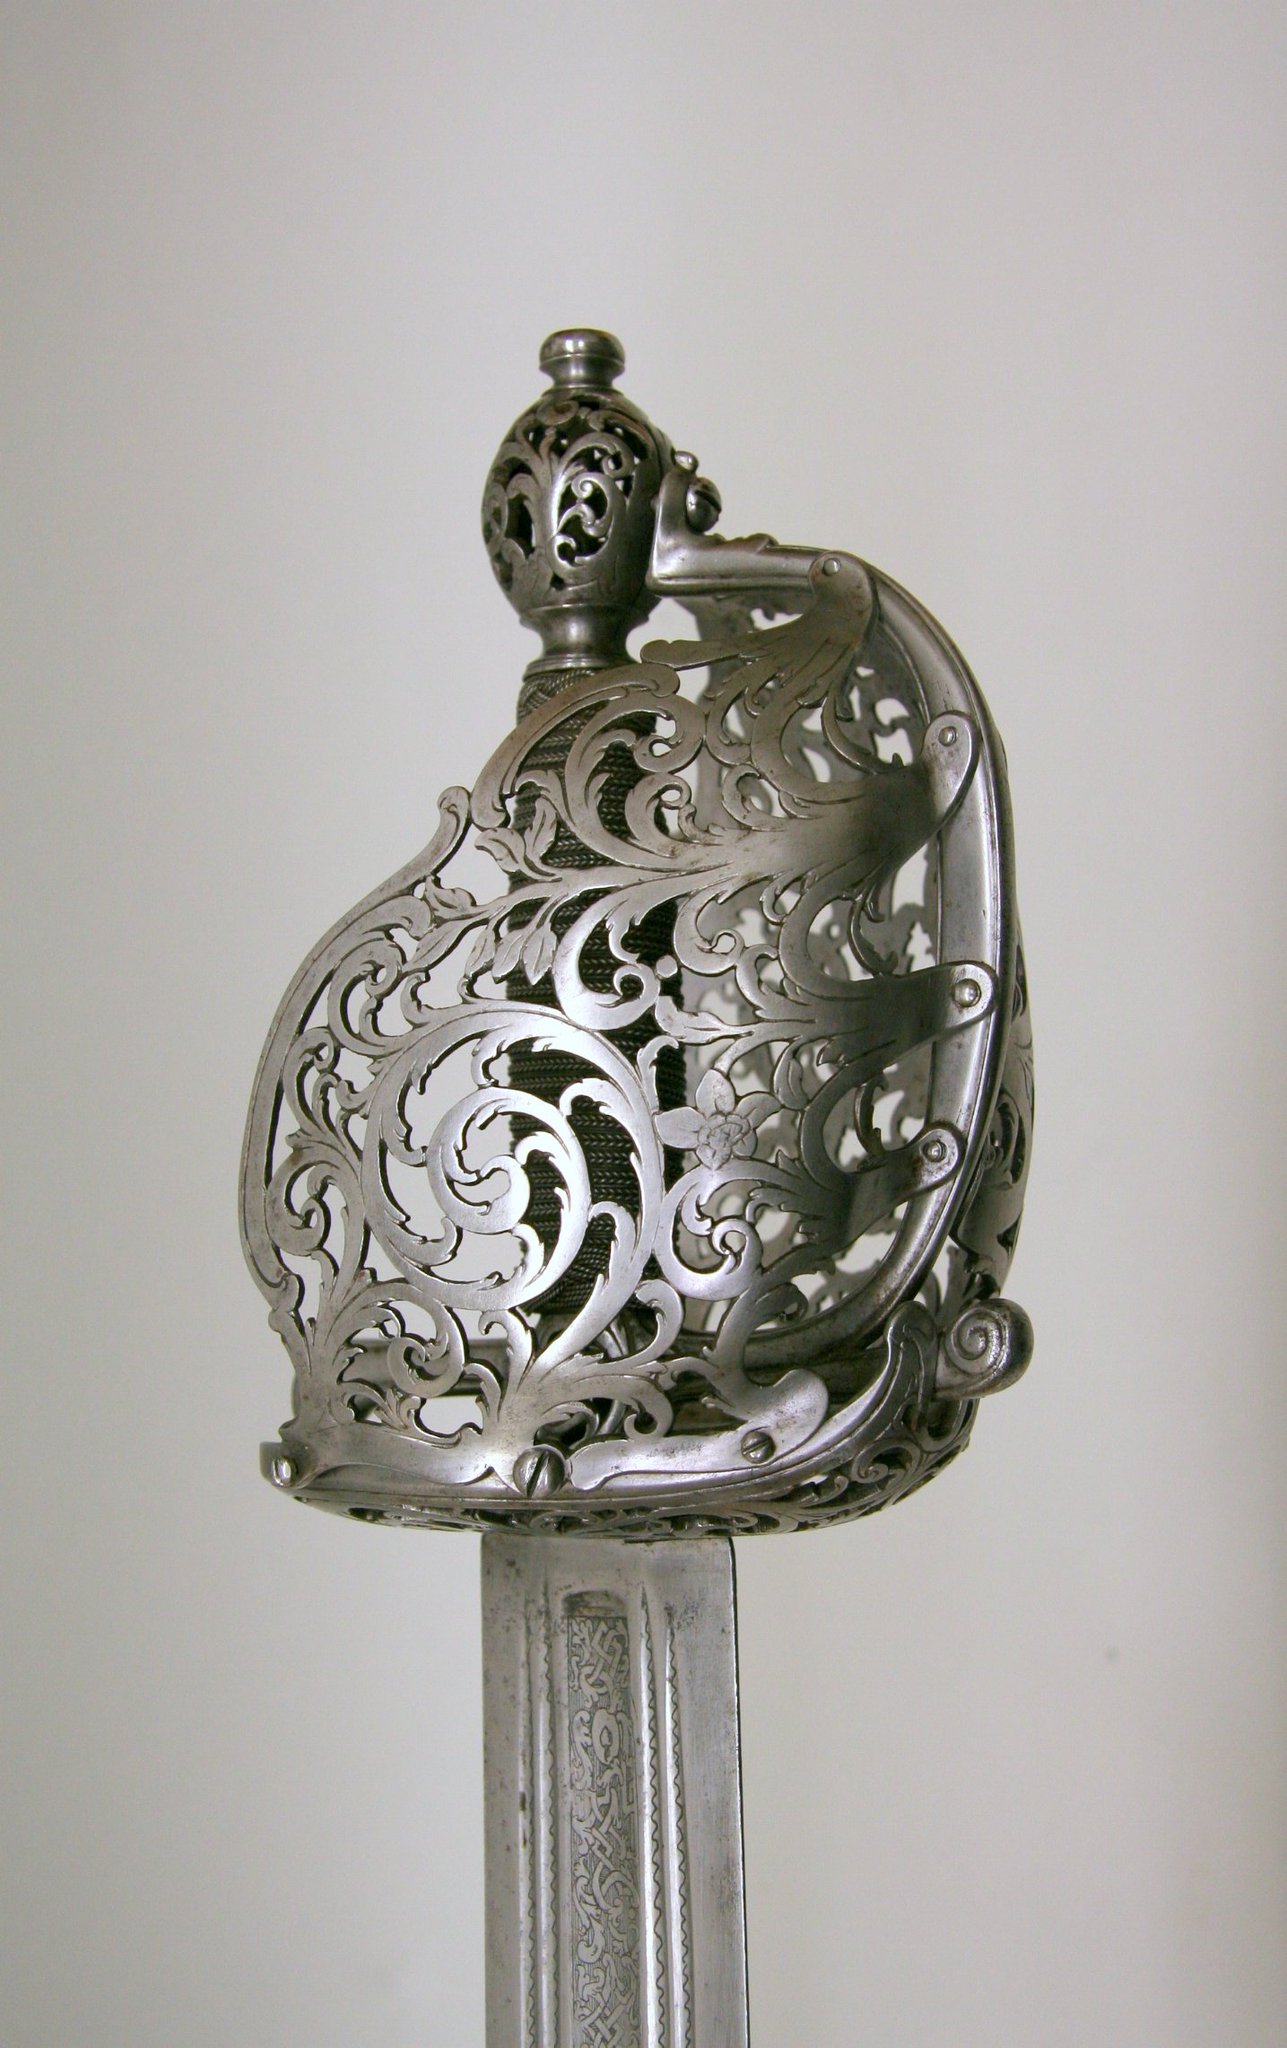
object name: broadsword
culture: german or swiss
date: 1590-1600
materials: steel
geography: switzerland